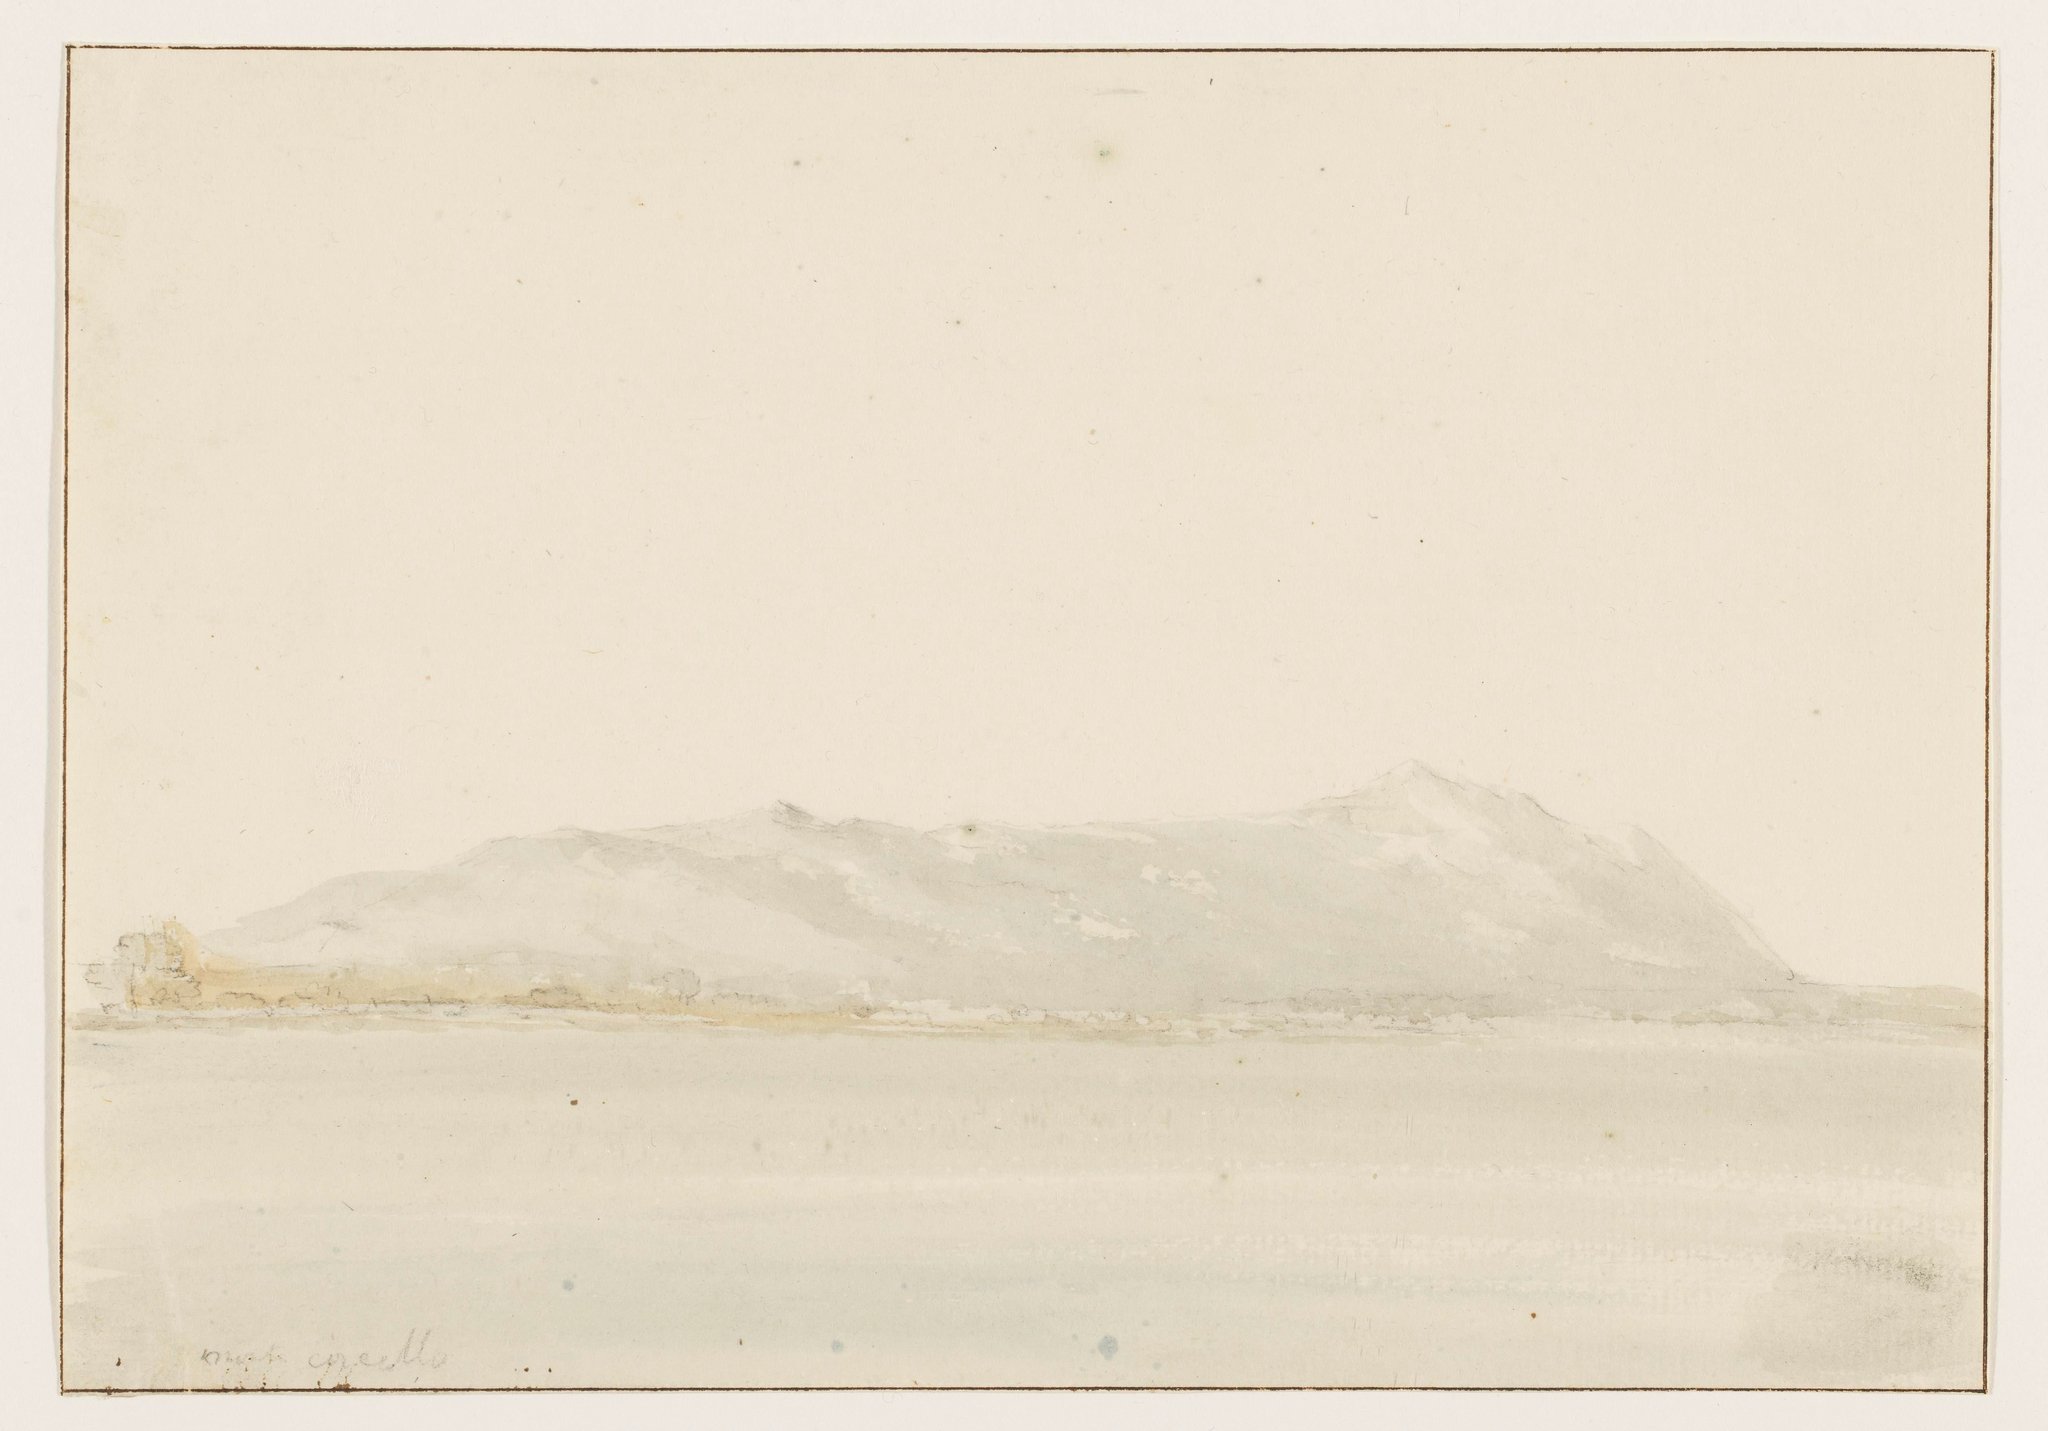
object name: drawing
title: Gezicht op Monte Circello vanaf een grote weg voor aankomst in Terracina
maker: louis ducros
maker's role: draughtsman, print maker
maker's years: 1748-1810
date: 1778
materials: chalk, paper, watercolor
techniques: brush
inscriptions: number: ‘No 1 Vue de Monte-Circello, prise du grand chemin, avant d'arriver à Terracina’